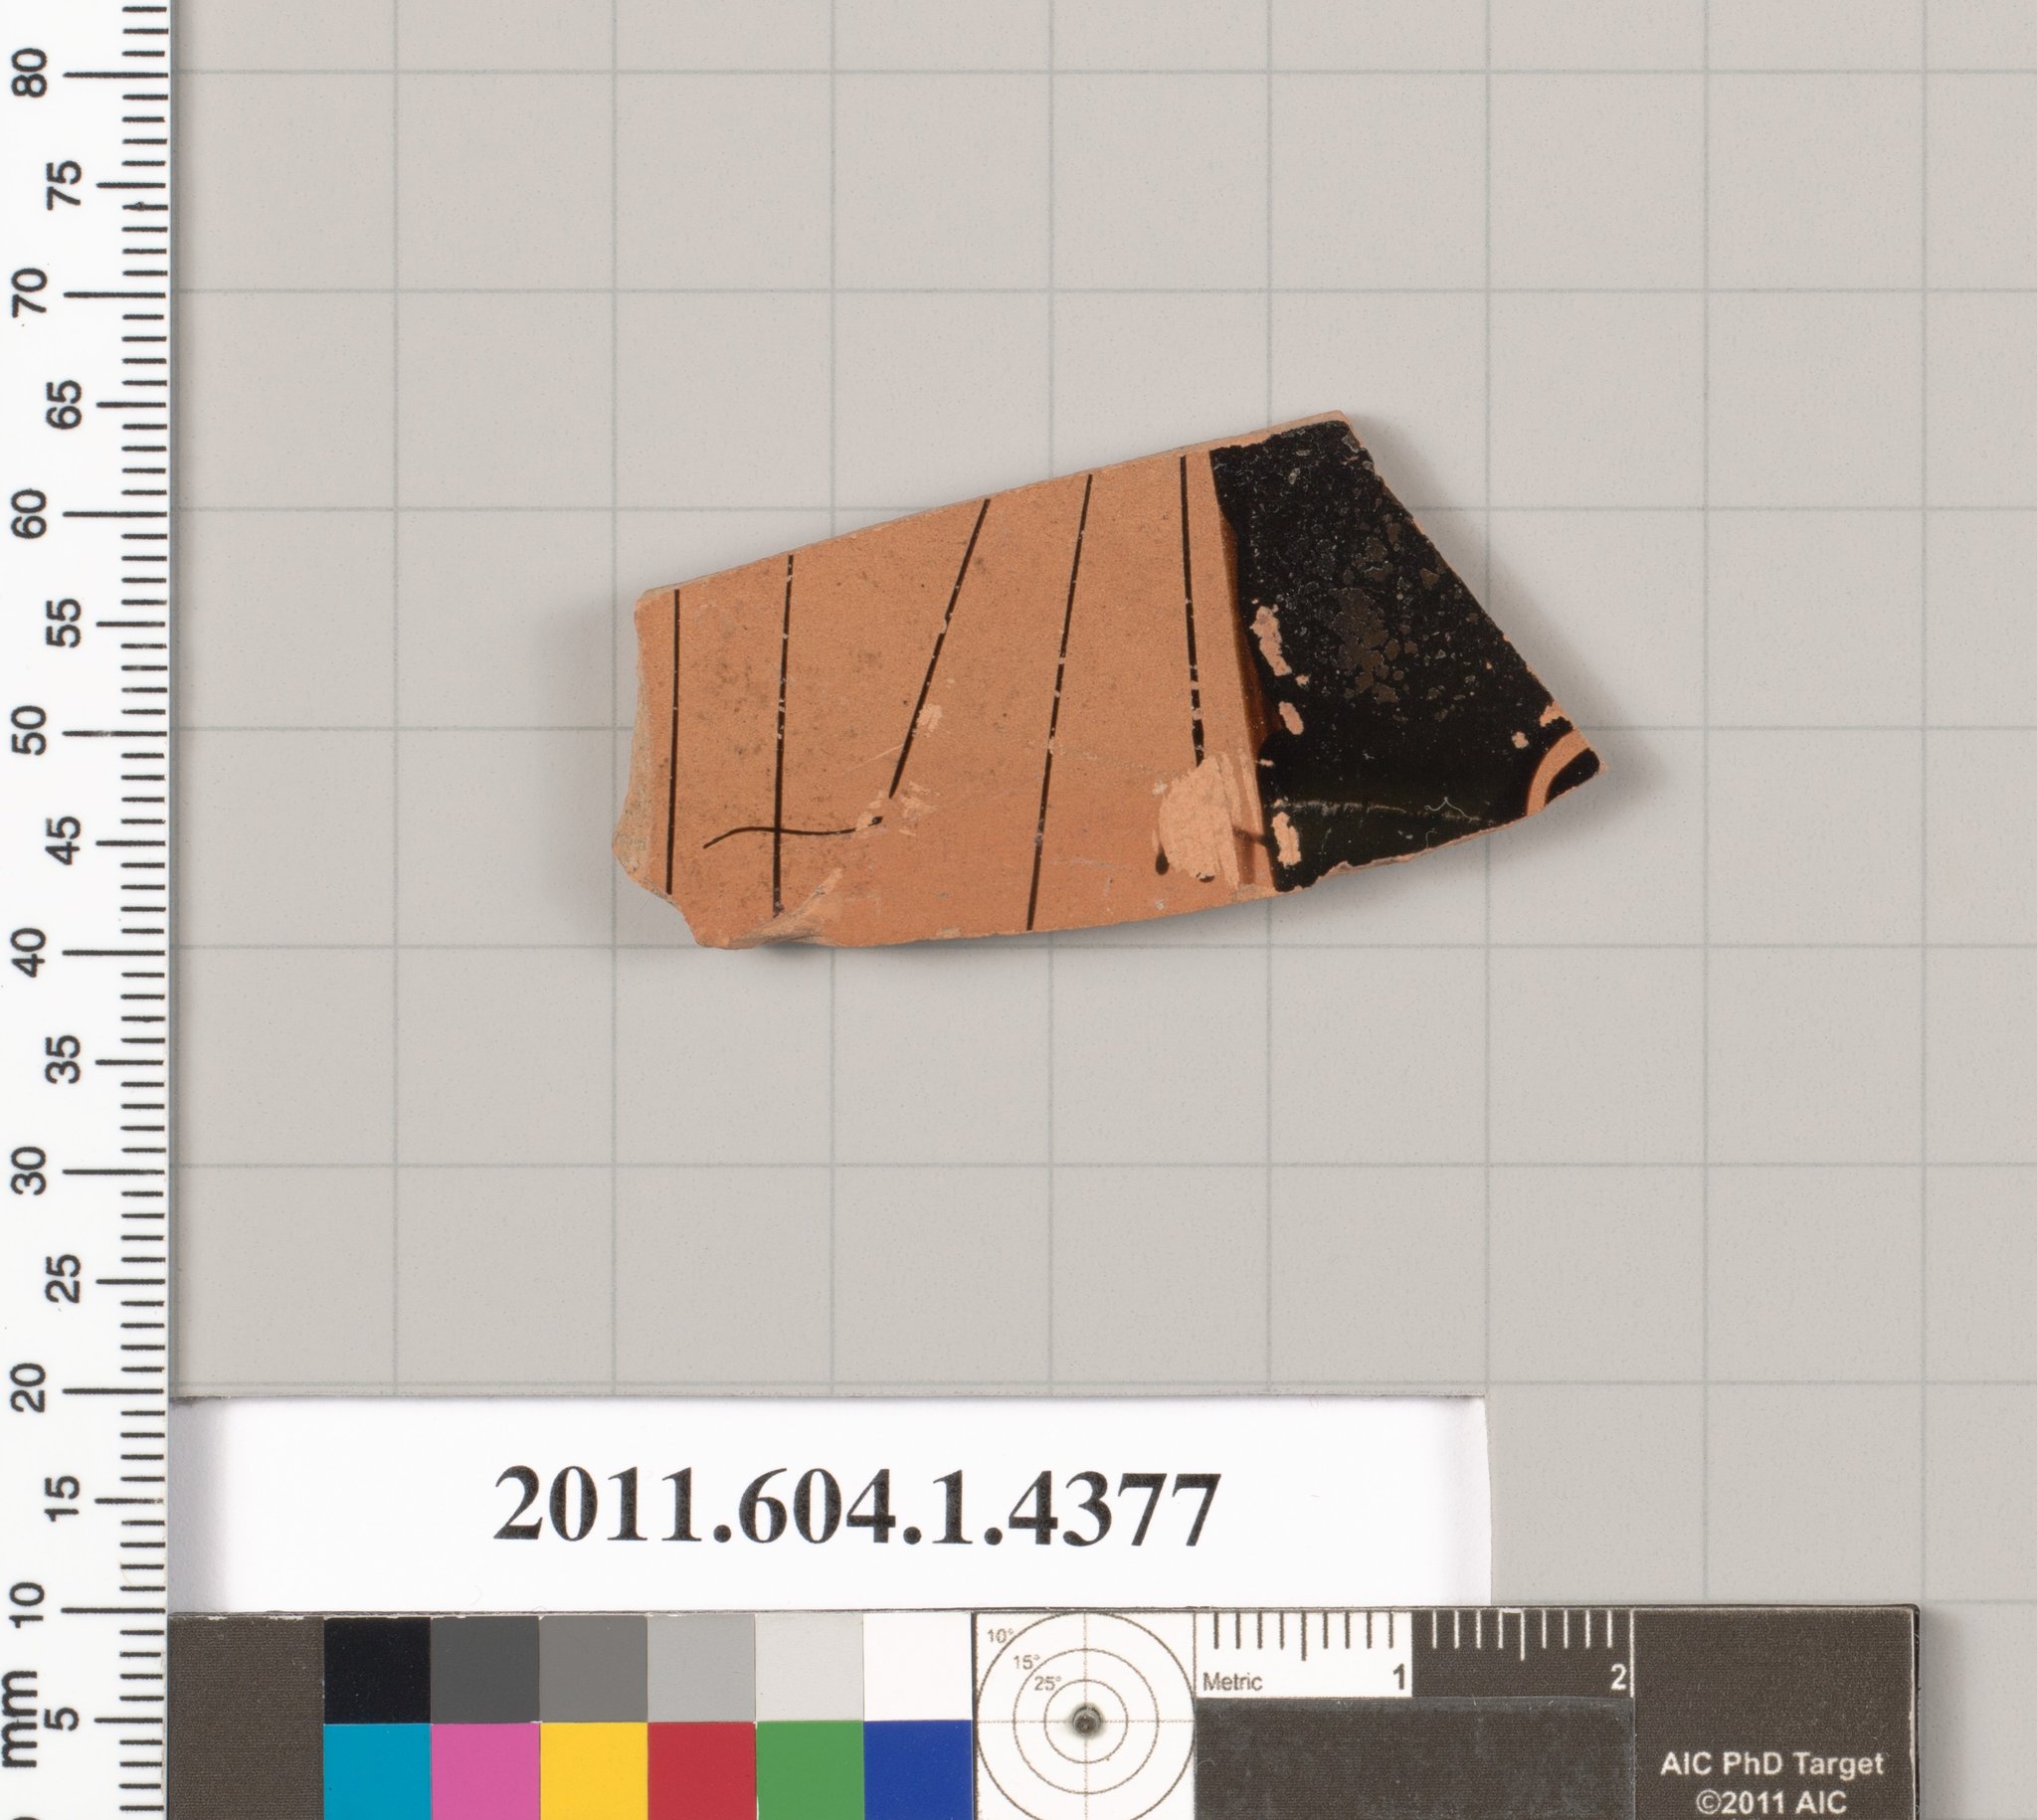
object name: kylix fragment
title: Terracotta fragment of a kylix (drinking cup)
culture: greek, attic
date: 475-451 BCE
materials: terracotta